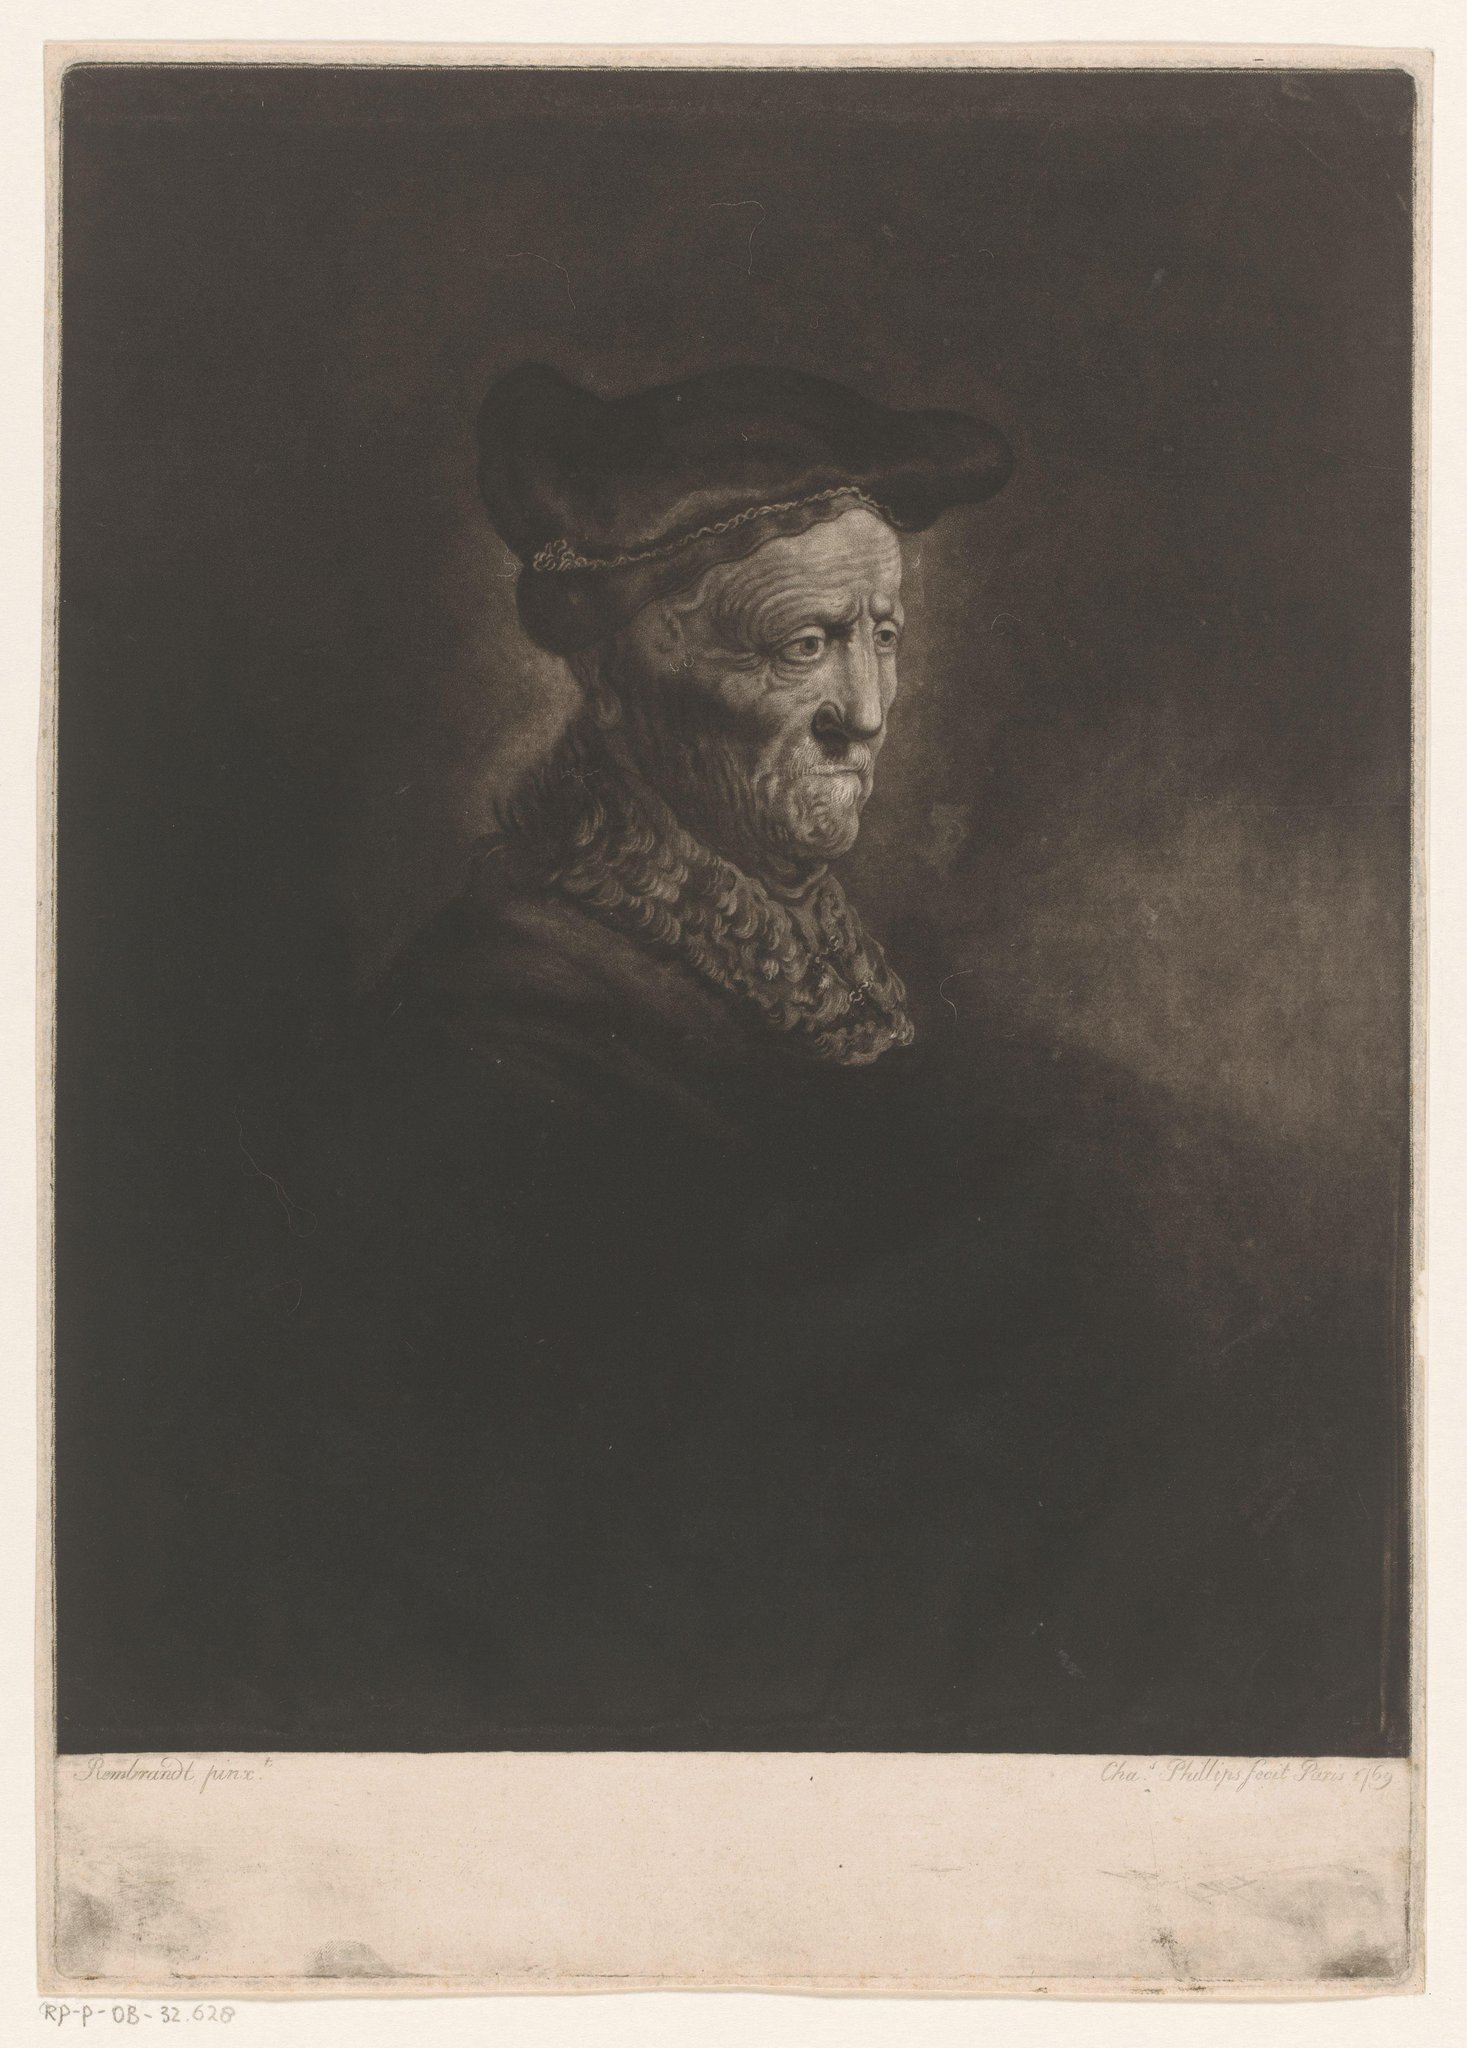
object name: print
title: Portret van een onbekende man met een baret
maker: charles phillips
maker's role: painter, print maker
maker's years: 1737-1787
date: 1769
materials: paper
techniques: mezzotint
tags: historical persons, head-gear: beret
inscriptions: collector's mark: Lugt 240